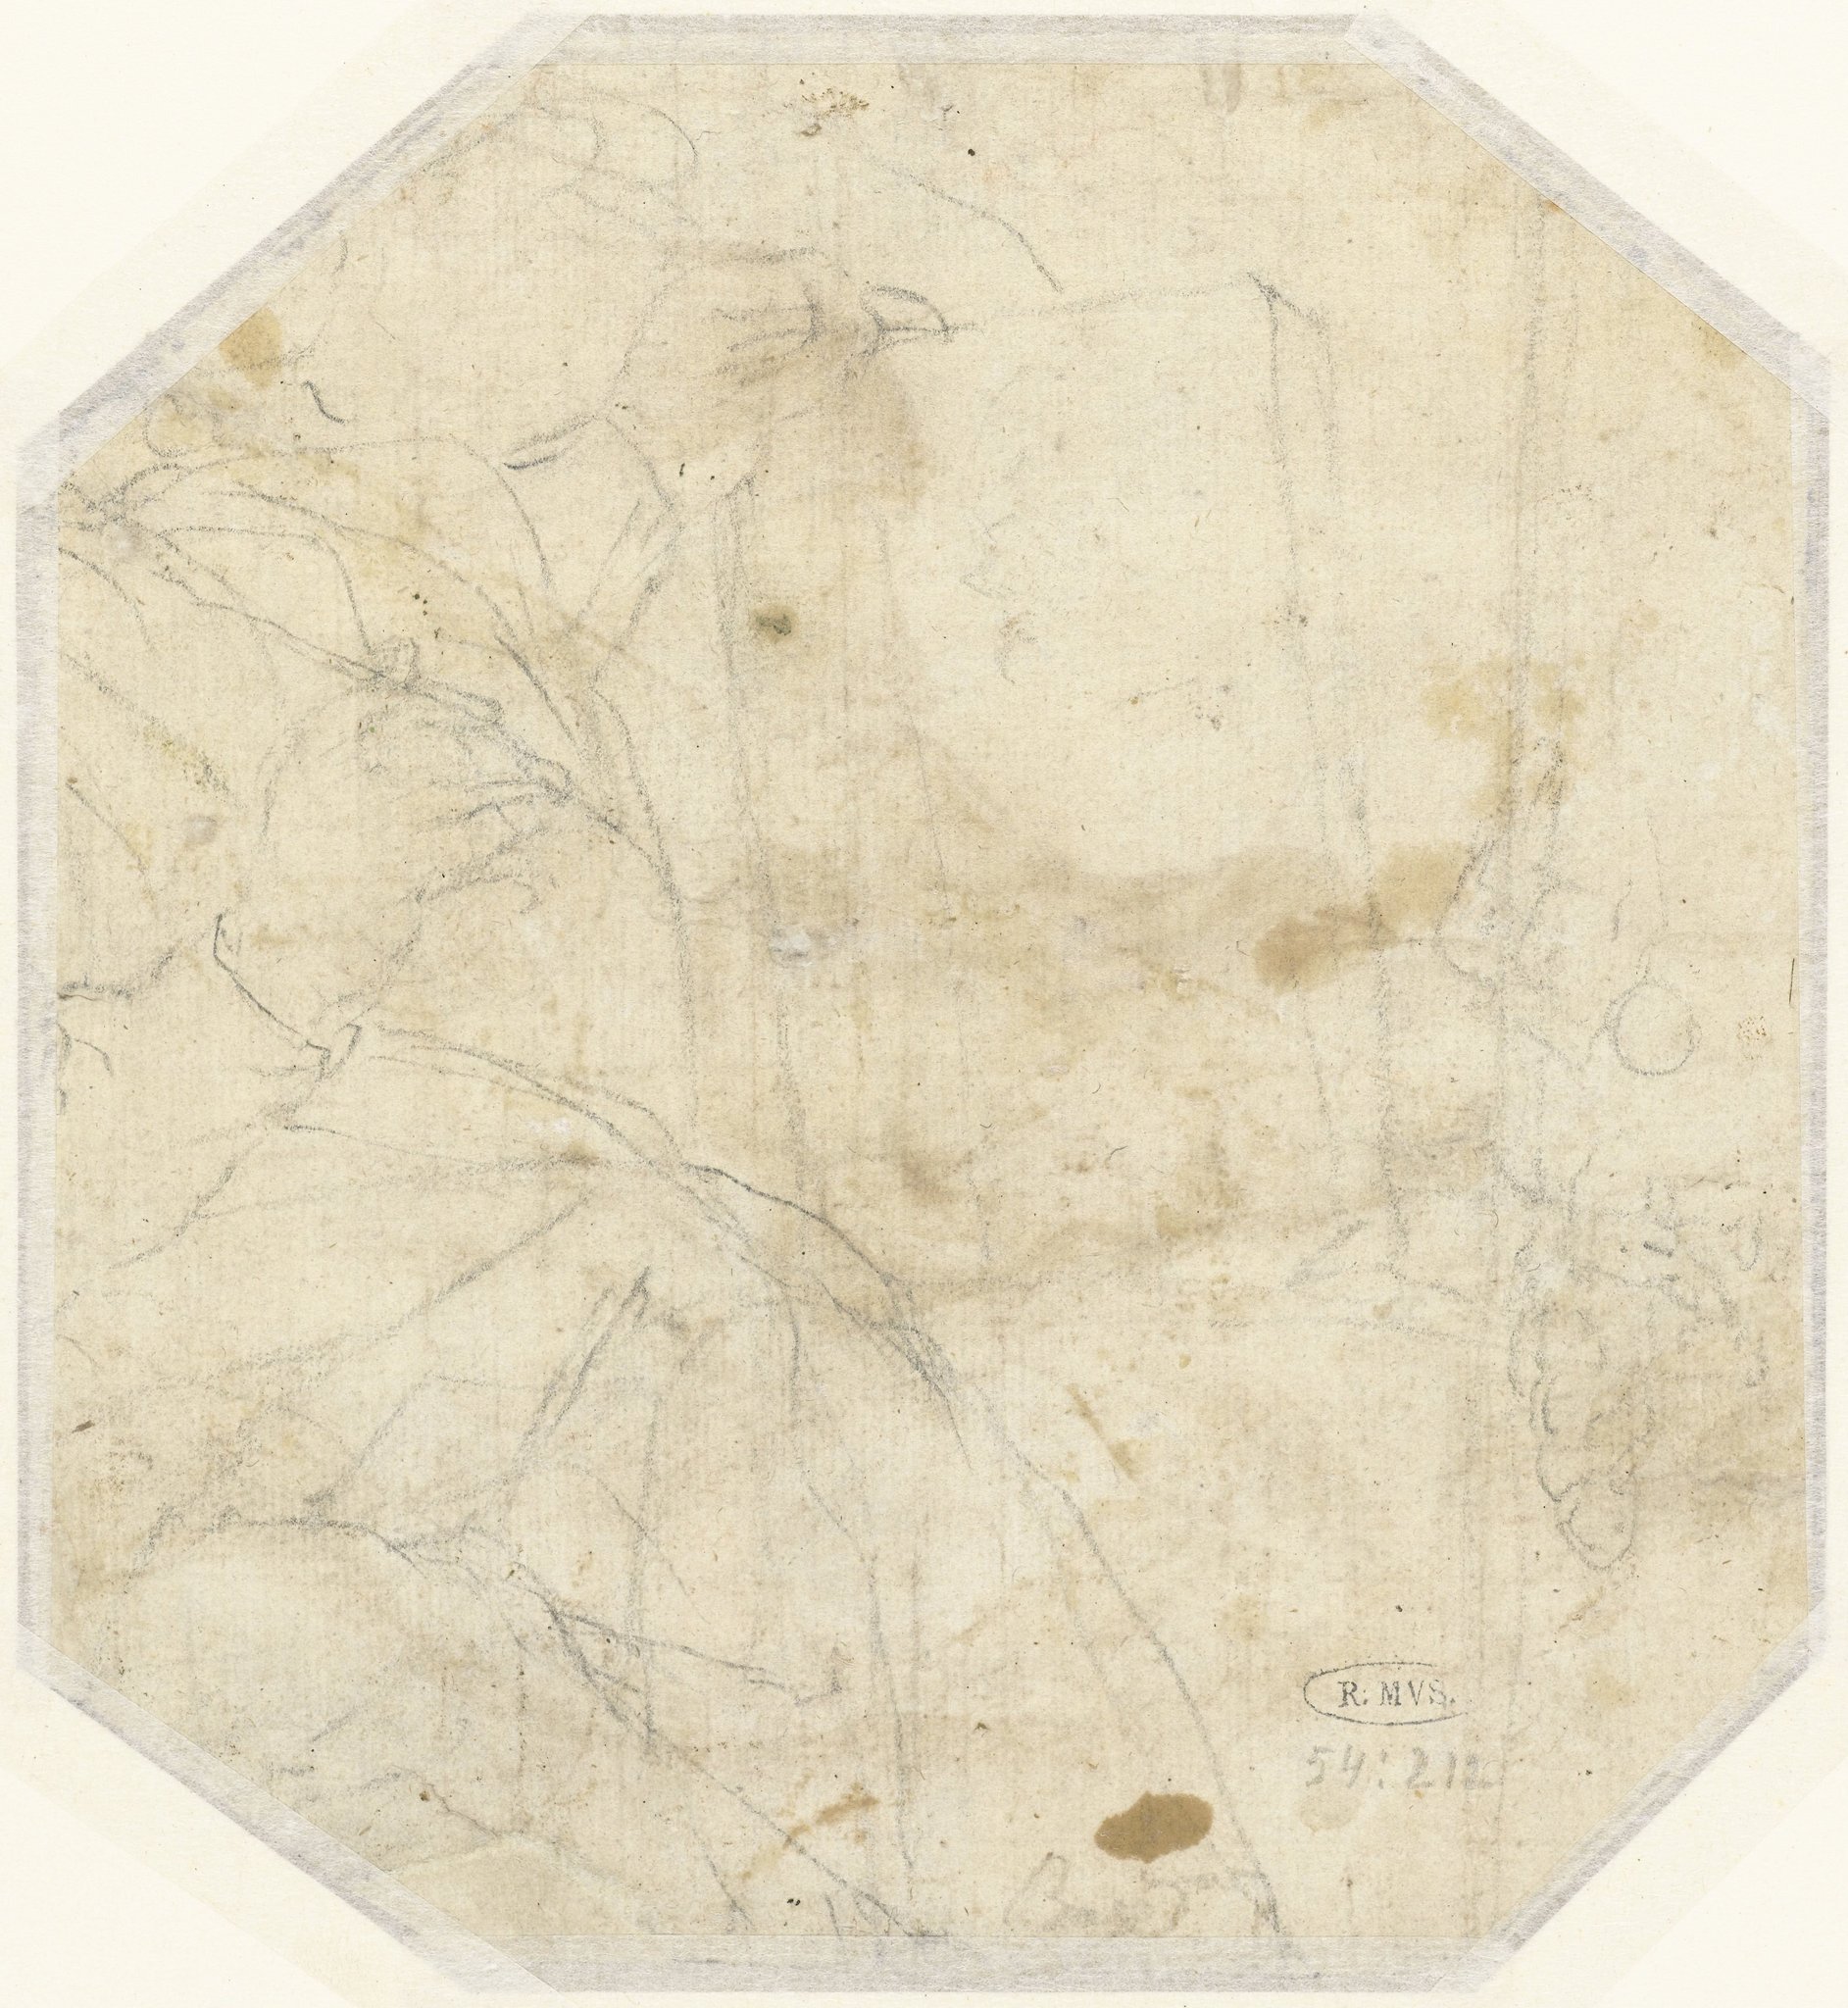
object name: drawing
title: Schets van een zittende figuur met een boek (?)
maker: Anonymous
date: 1600-1699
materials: chalk, paper